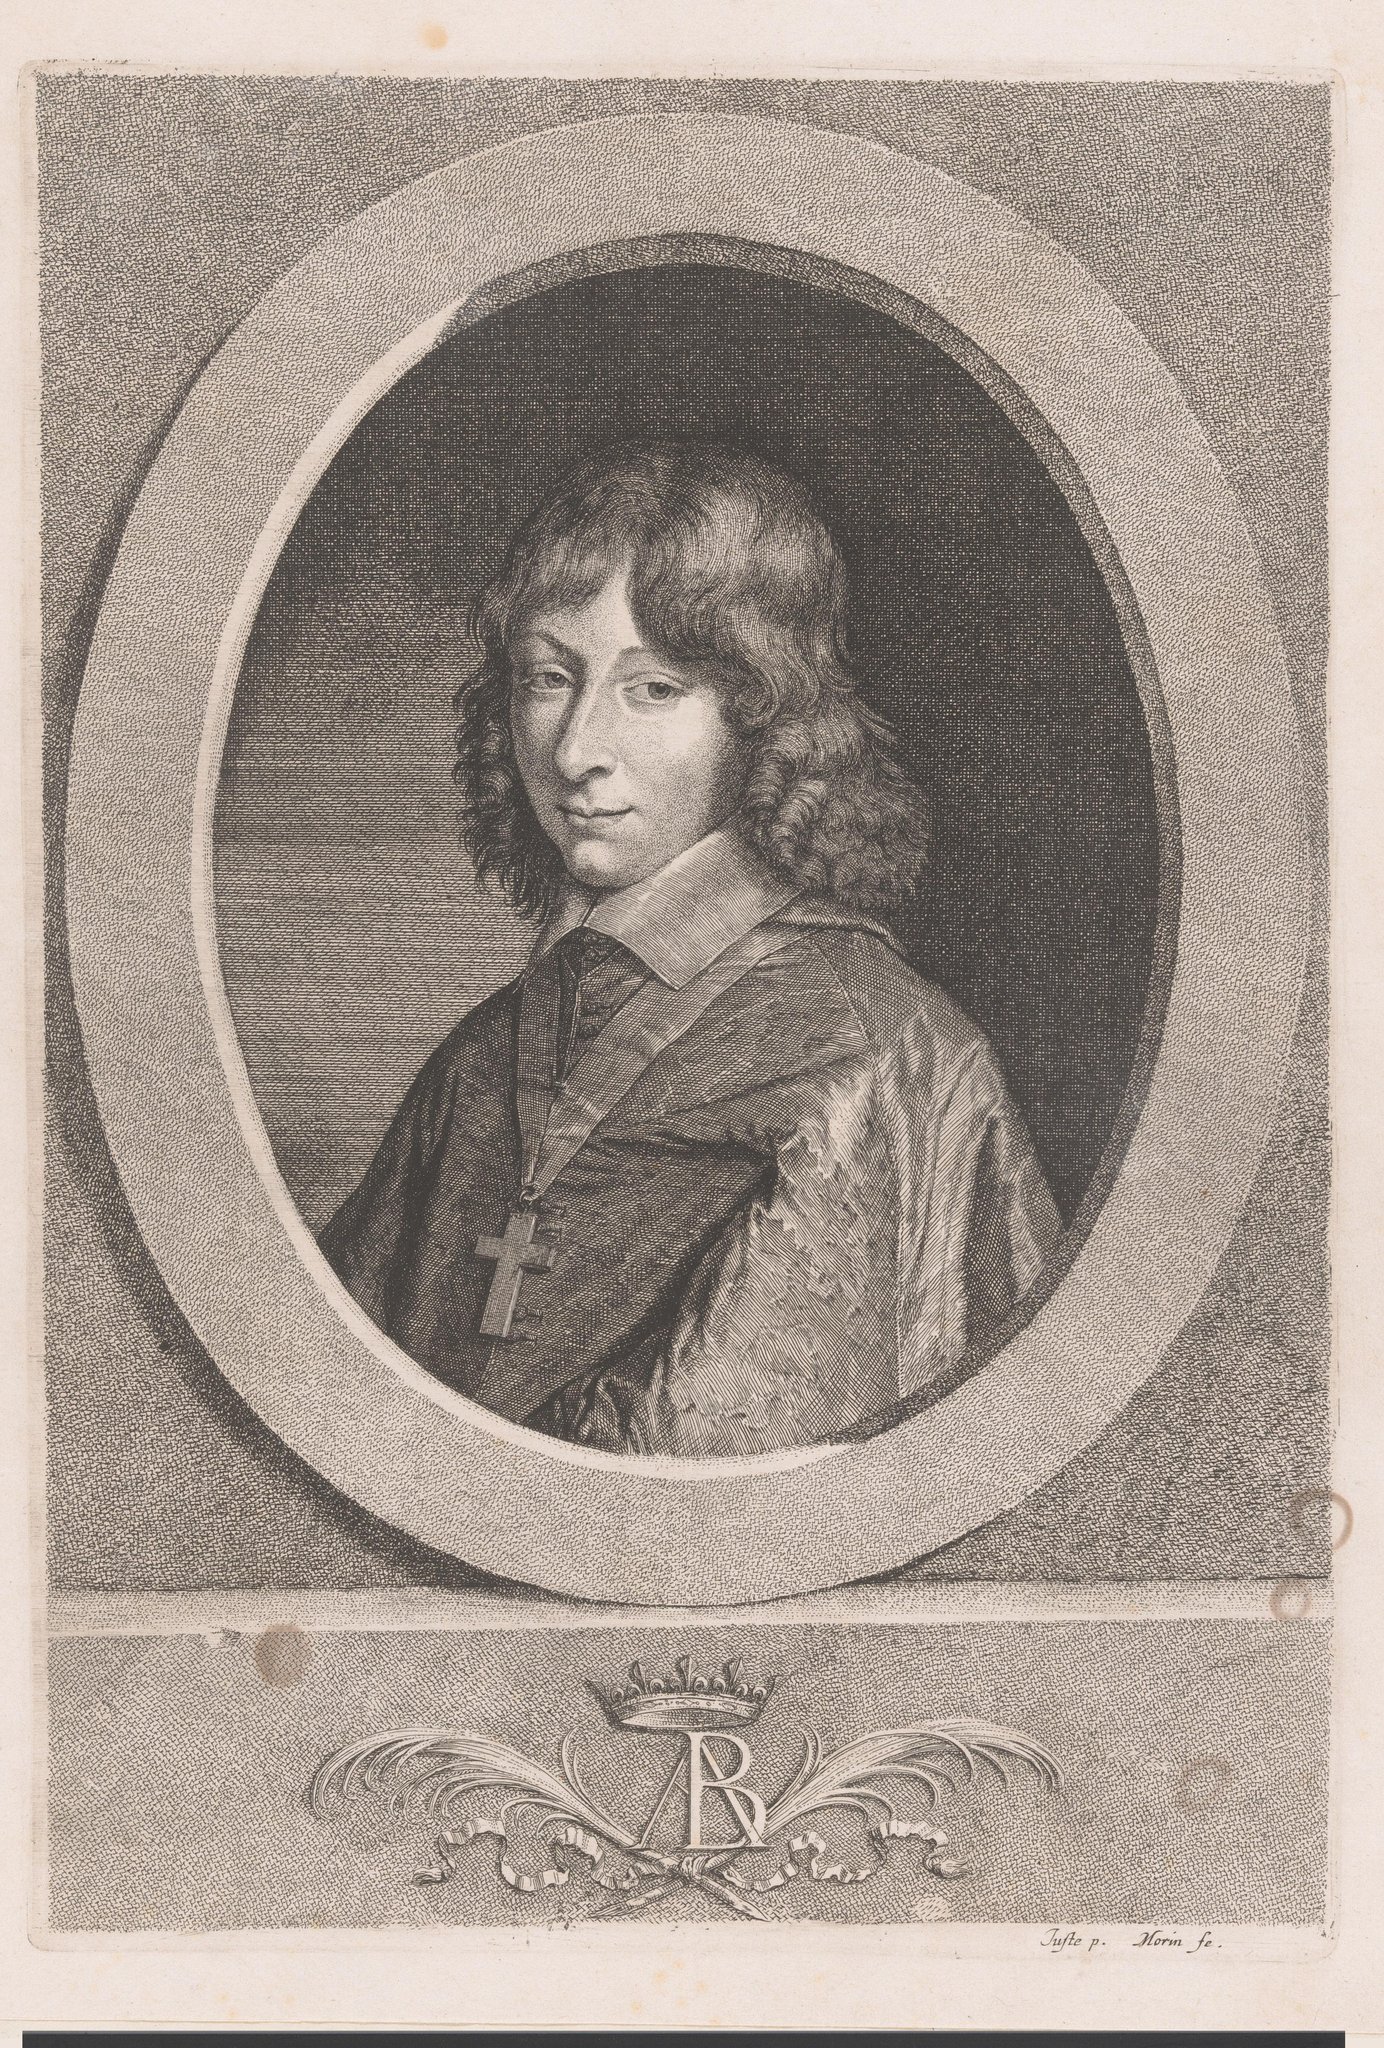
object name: print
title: Portret van Armand de Bourbon-Condé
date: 1640-1650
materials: paper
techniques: etching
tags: paris, historical persons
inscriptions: collector's mark: Lugt 2228